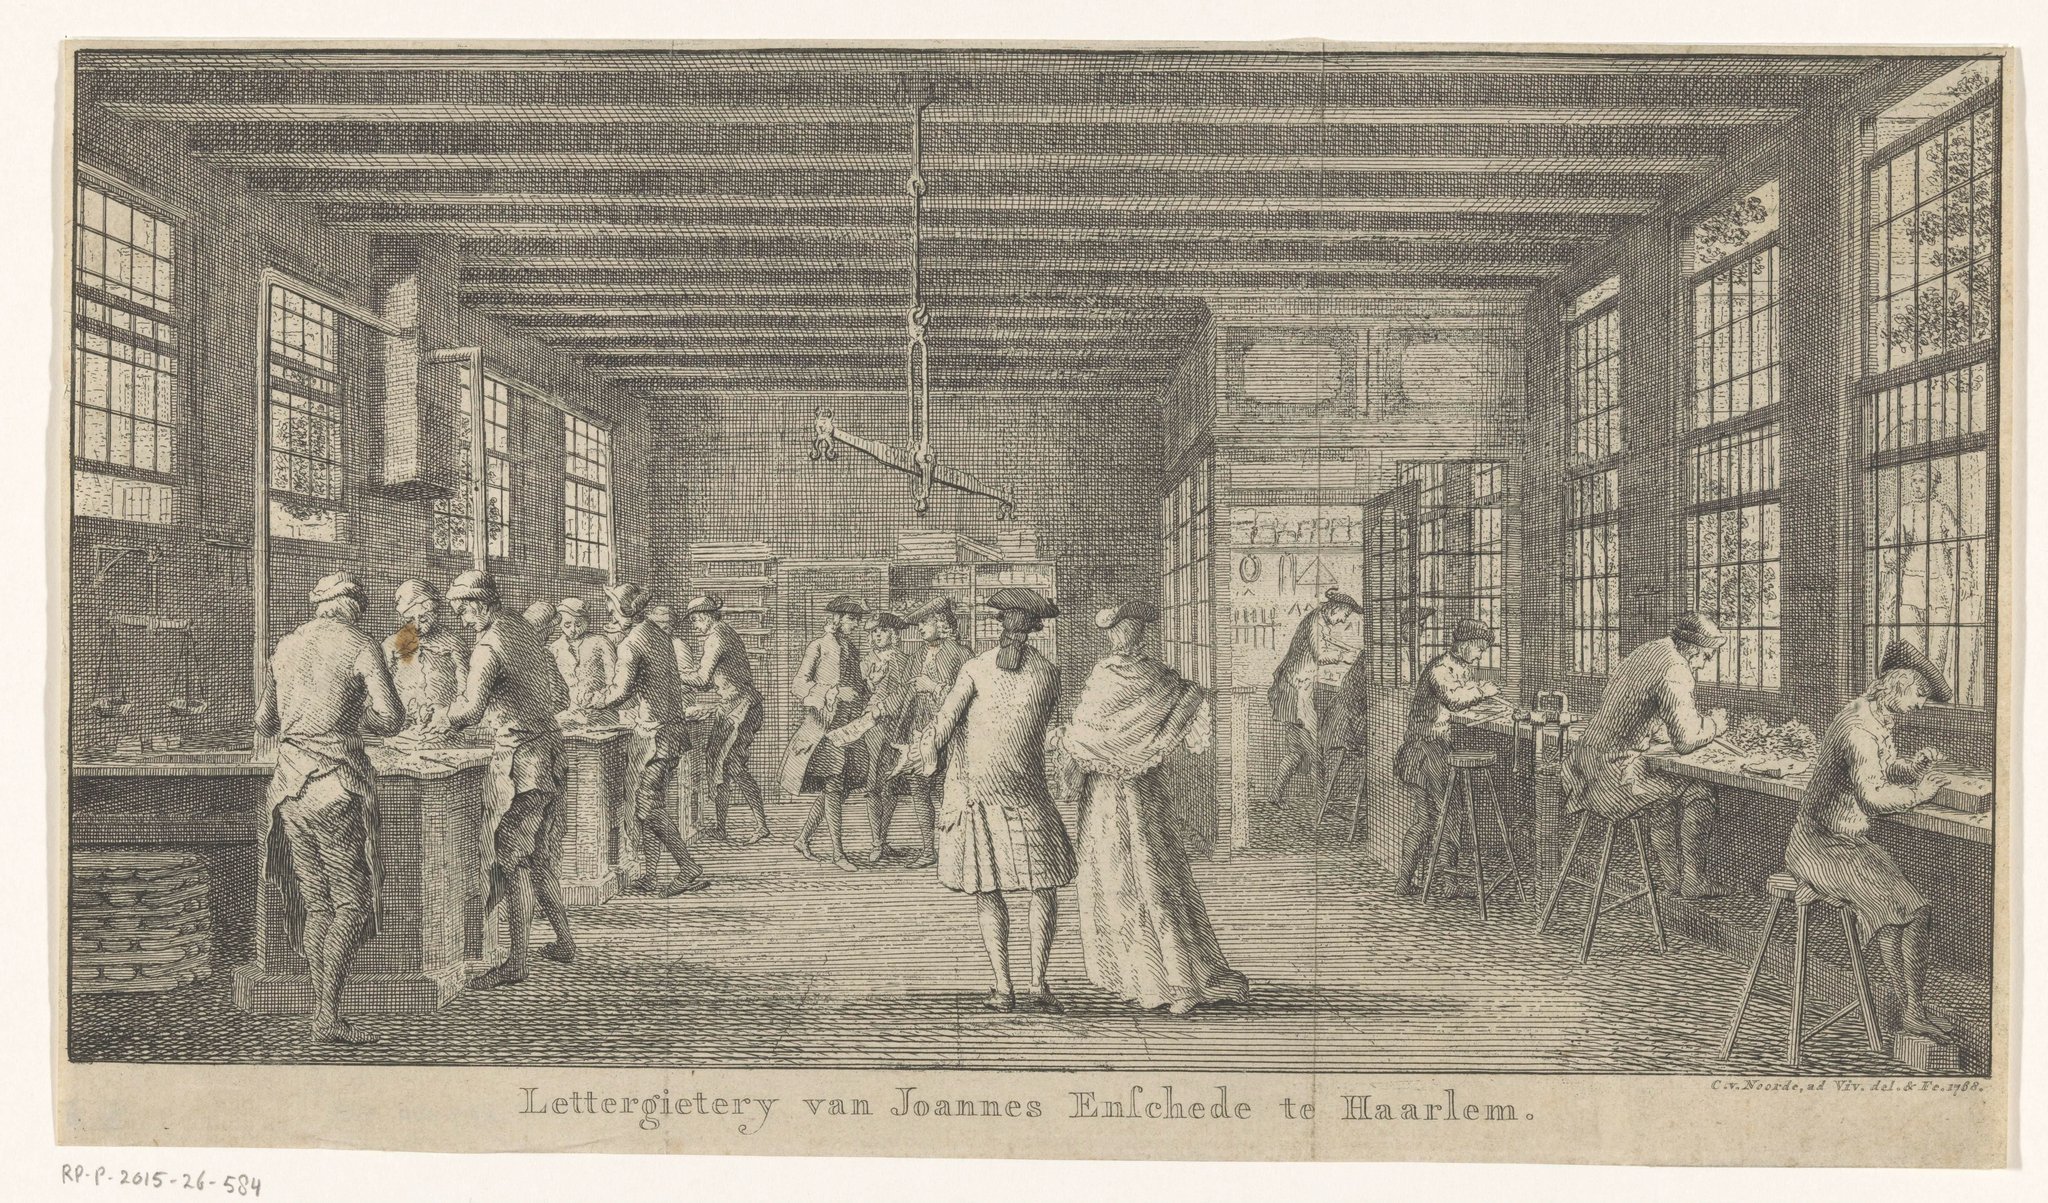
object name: print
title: Lettergietery van Joannes Enschede te Haarlem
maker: cornelis van noorde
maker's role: draughtsman, print maker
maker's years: 1731-1795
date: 1788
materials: paper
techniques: engraving, etching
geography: haarlem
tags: publishing, publisher (+ in workshop, laboratory), printing, printing office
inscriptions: collector's mark: Lugt 2228, collector's mark: Lugt 4779, watermark, collector's mark: Lugt 4780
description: Zicht in de lettergieterij van Johannes Enschedé te Haarlem. In het midden een man en een vrouw op de rug gezien. Links en rechts zijn mensen onder de ramen aan het werk.